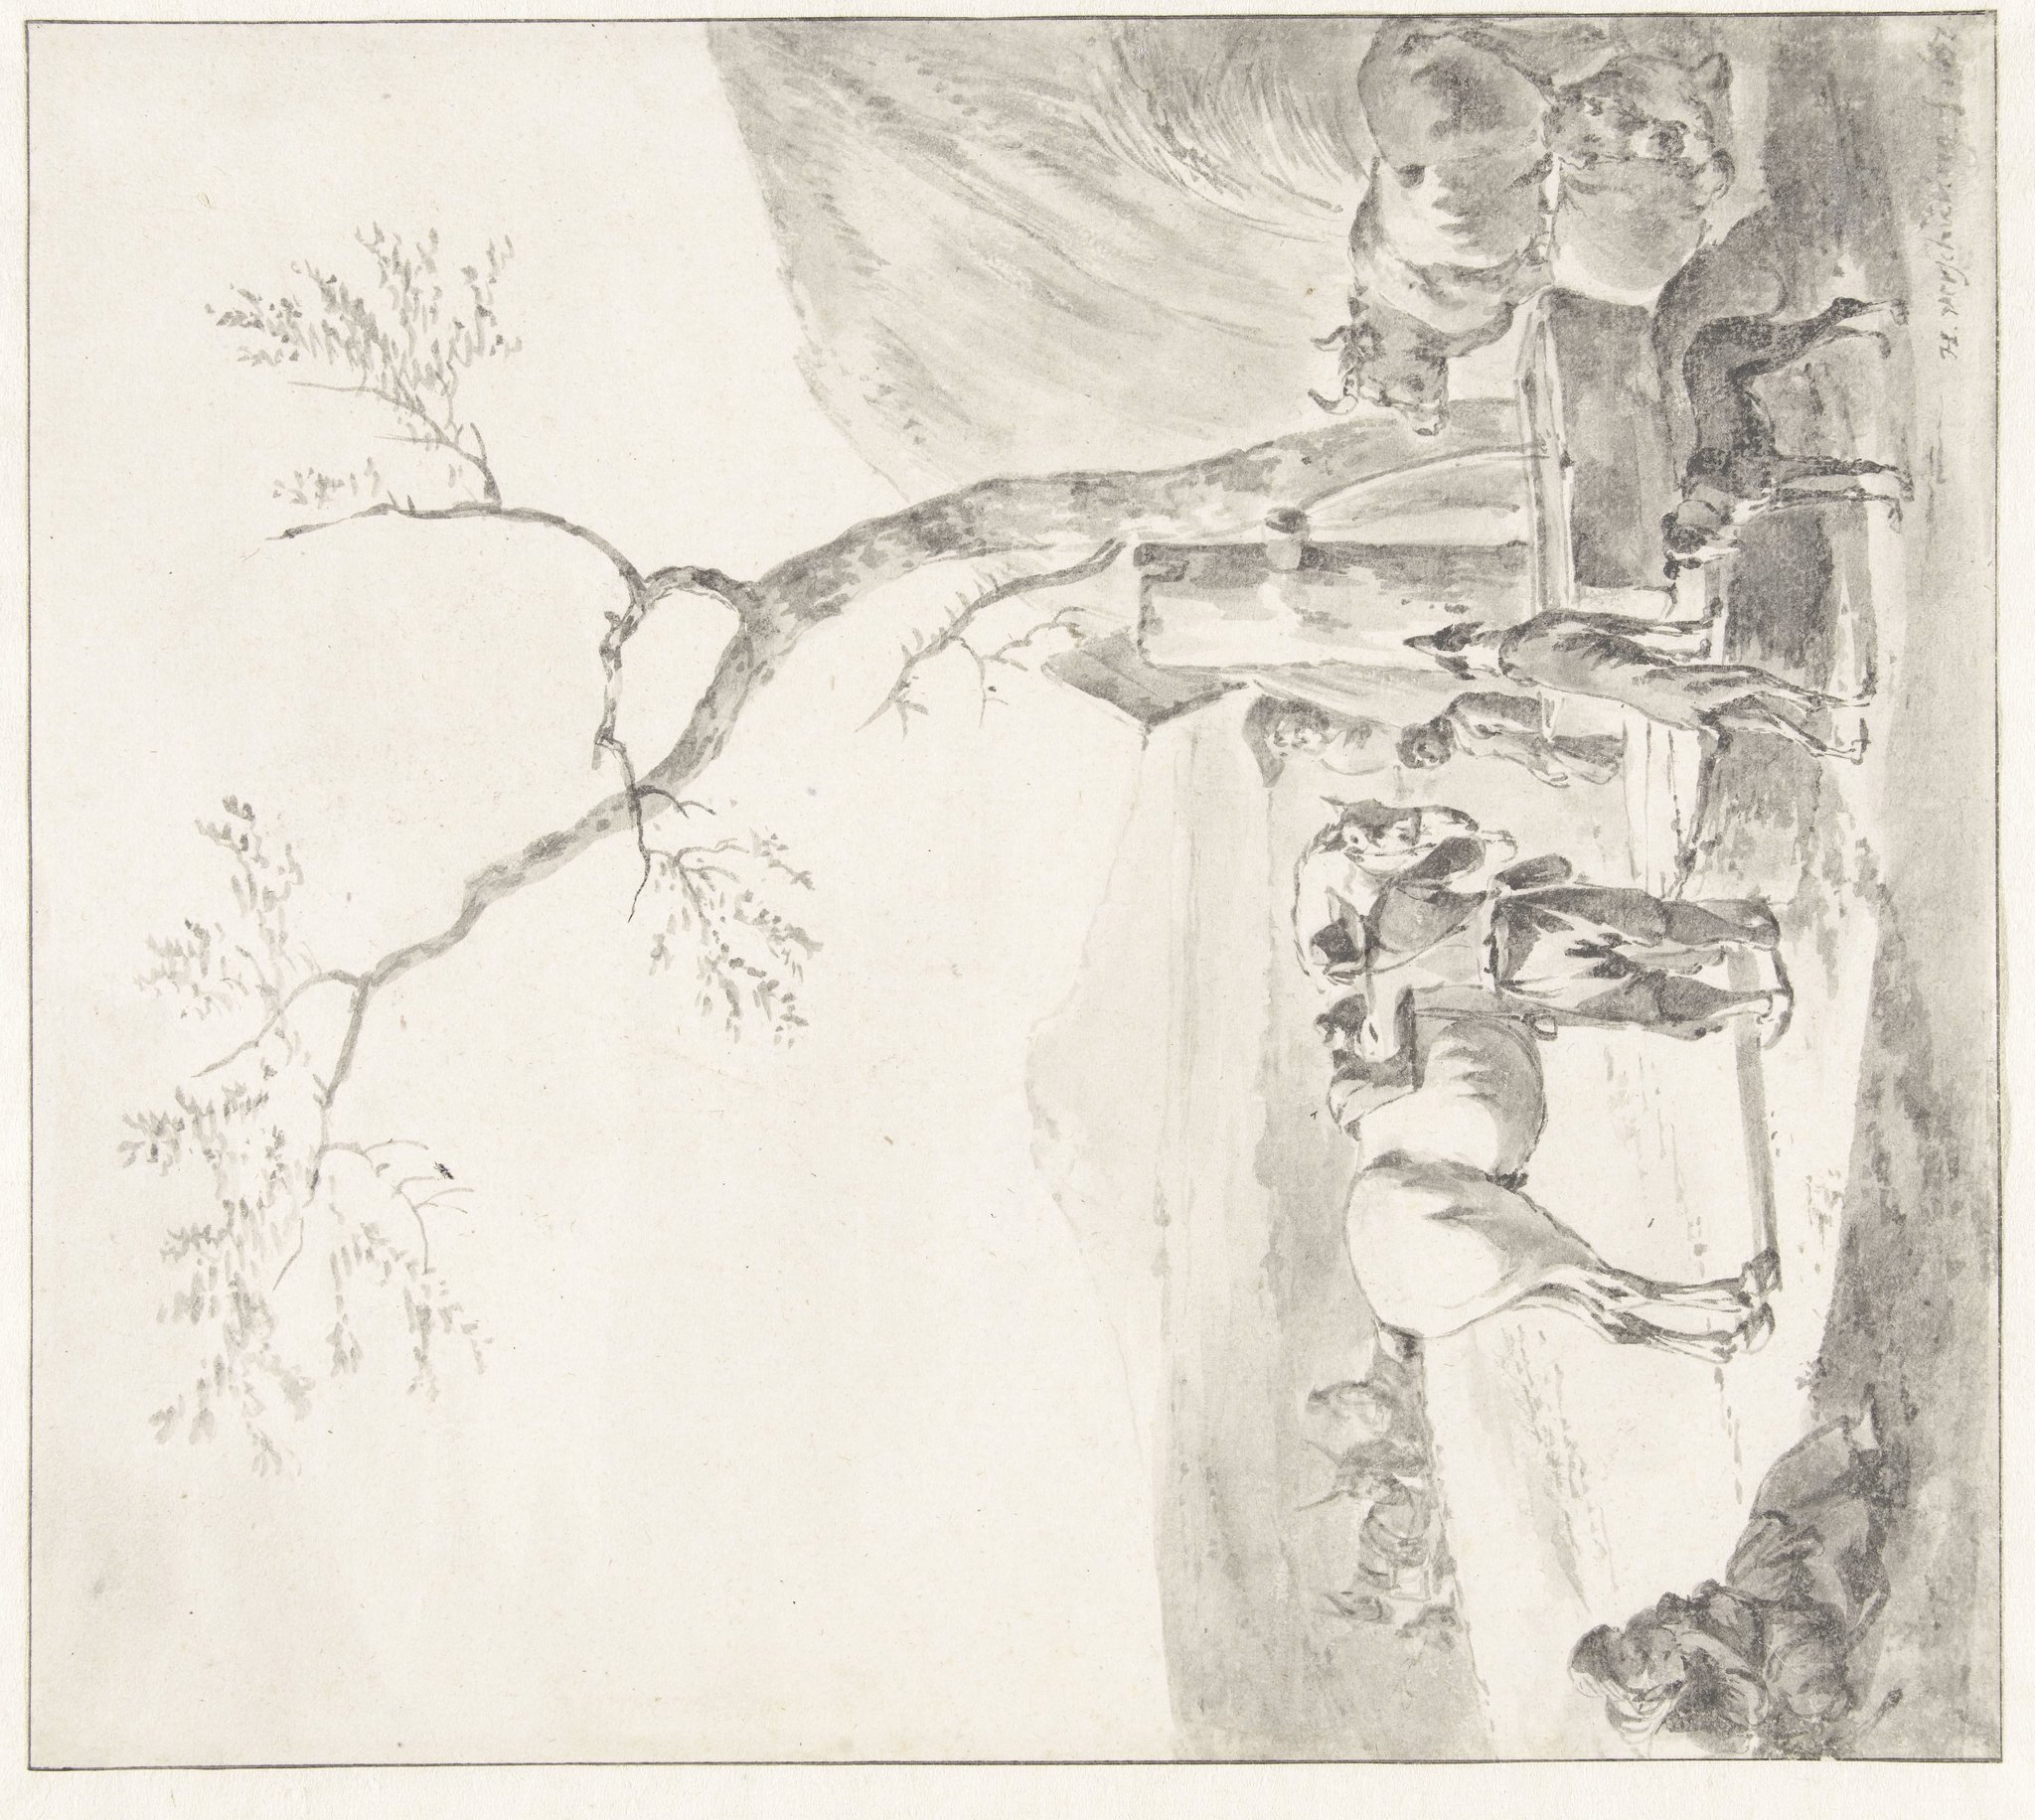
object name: drawing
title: Herders bij een drinkbak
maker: hendrik verschuring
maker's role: draughtsman, print maker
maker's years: 1627-1690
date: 1657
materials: paper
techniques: brush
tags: low hill country, herd, flock